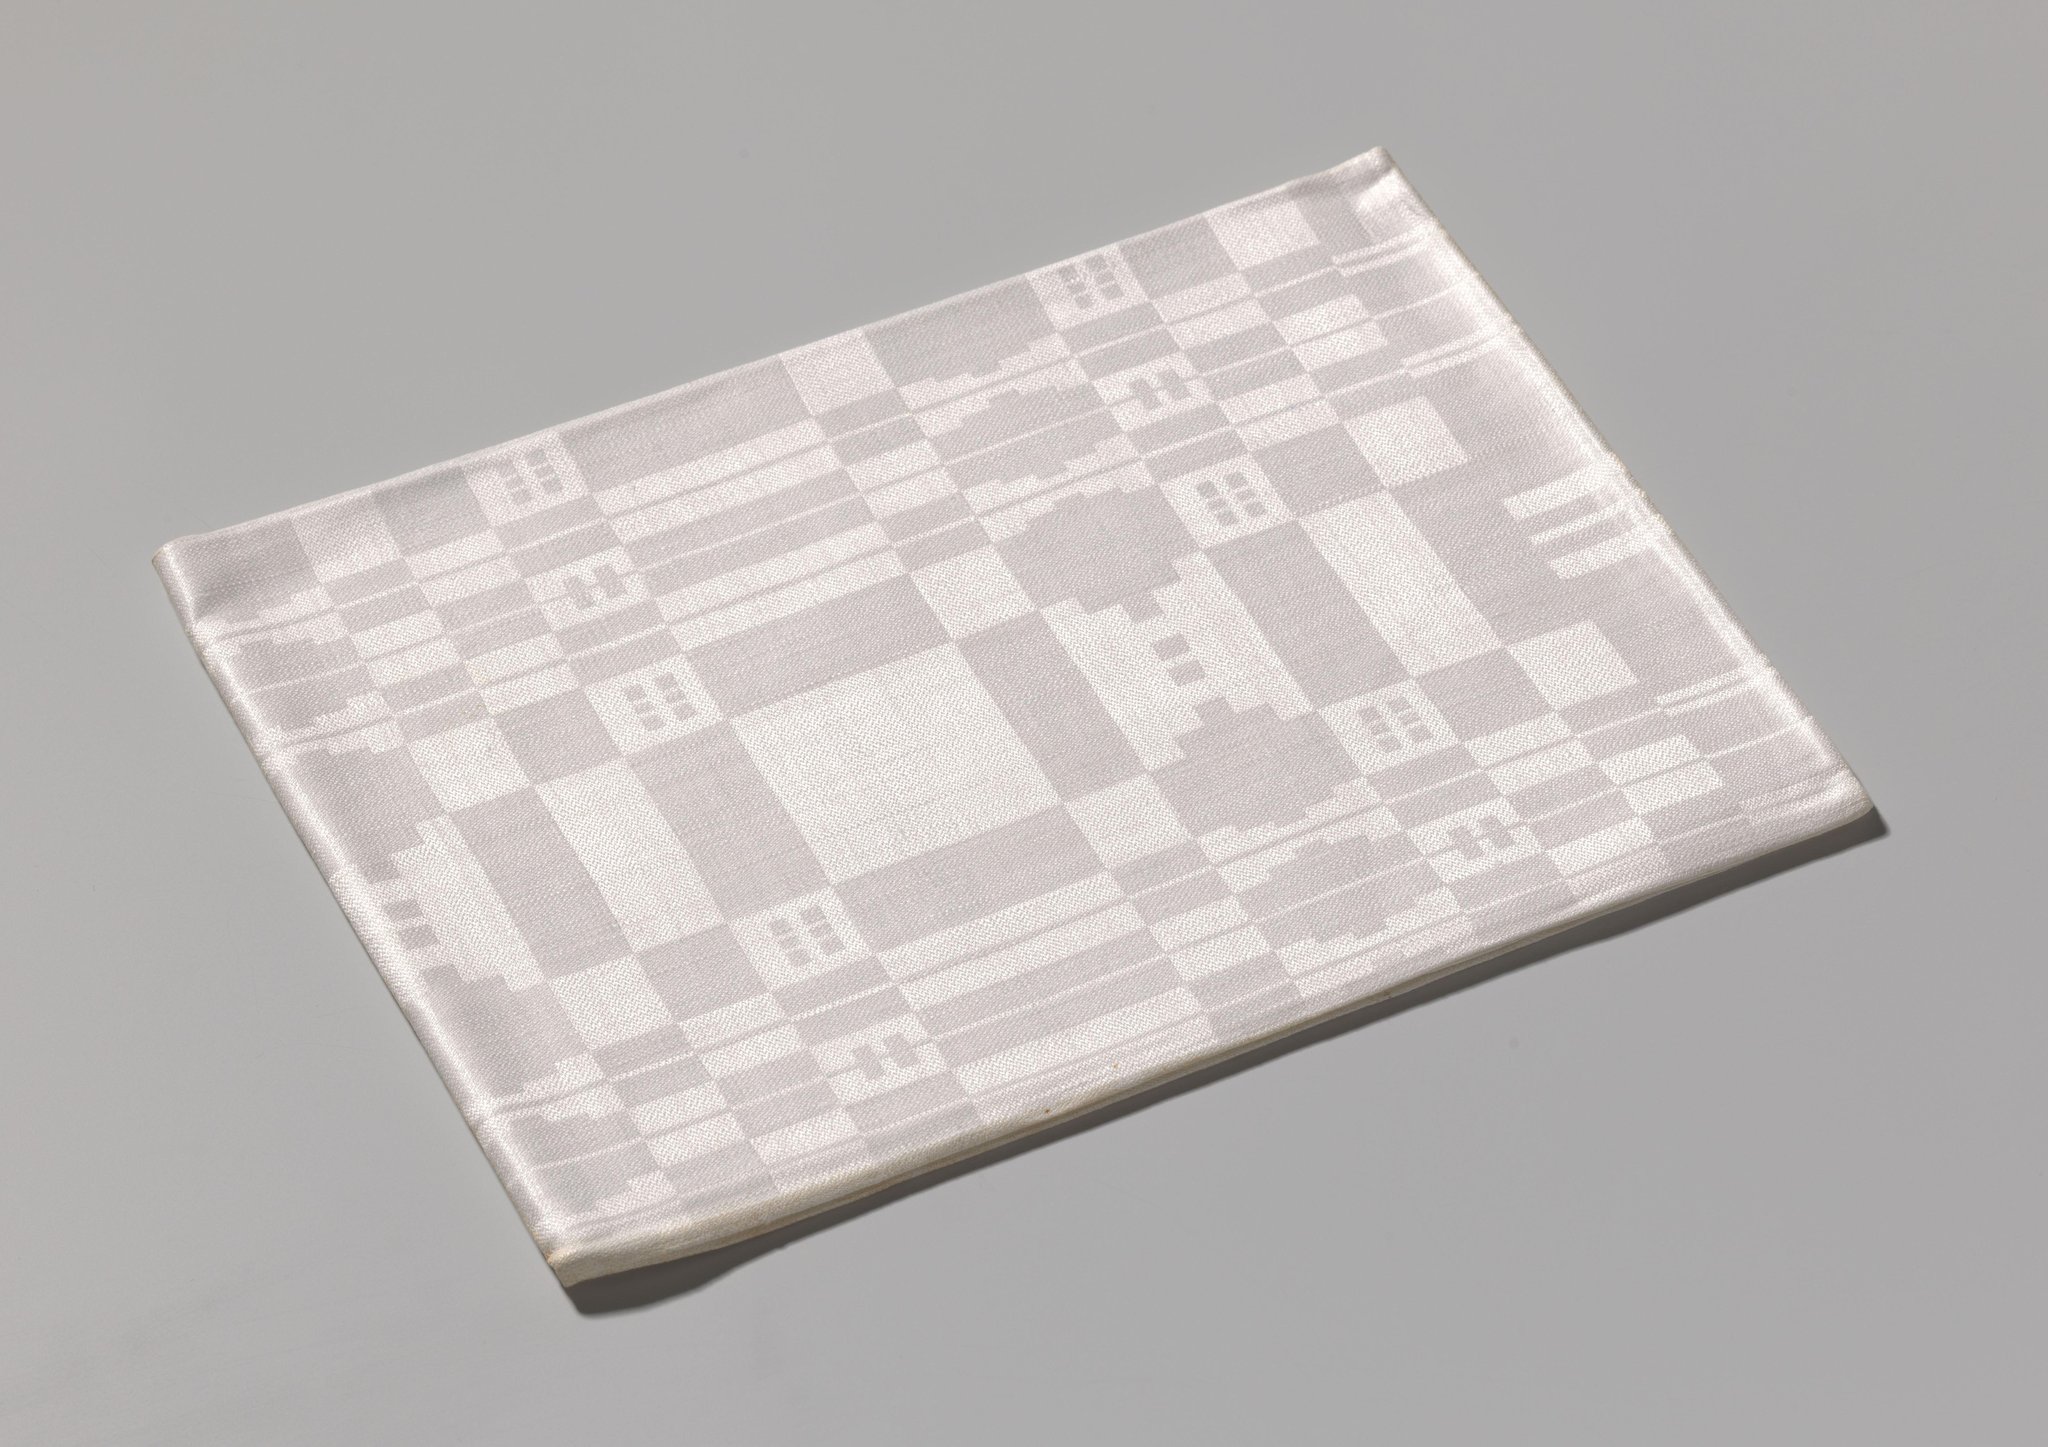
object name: napkin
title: Servet van linnen met pellenpatroon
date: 1742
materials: linen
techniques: peeled fabric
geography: northern netherlands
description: Wit linnendamasten servet met pellenpatroon, genaamd "Torenwerk". Merk kroon WG 44 1742.